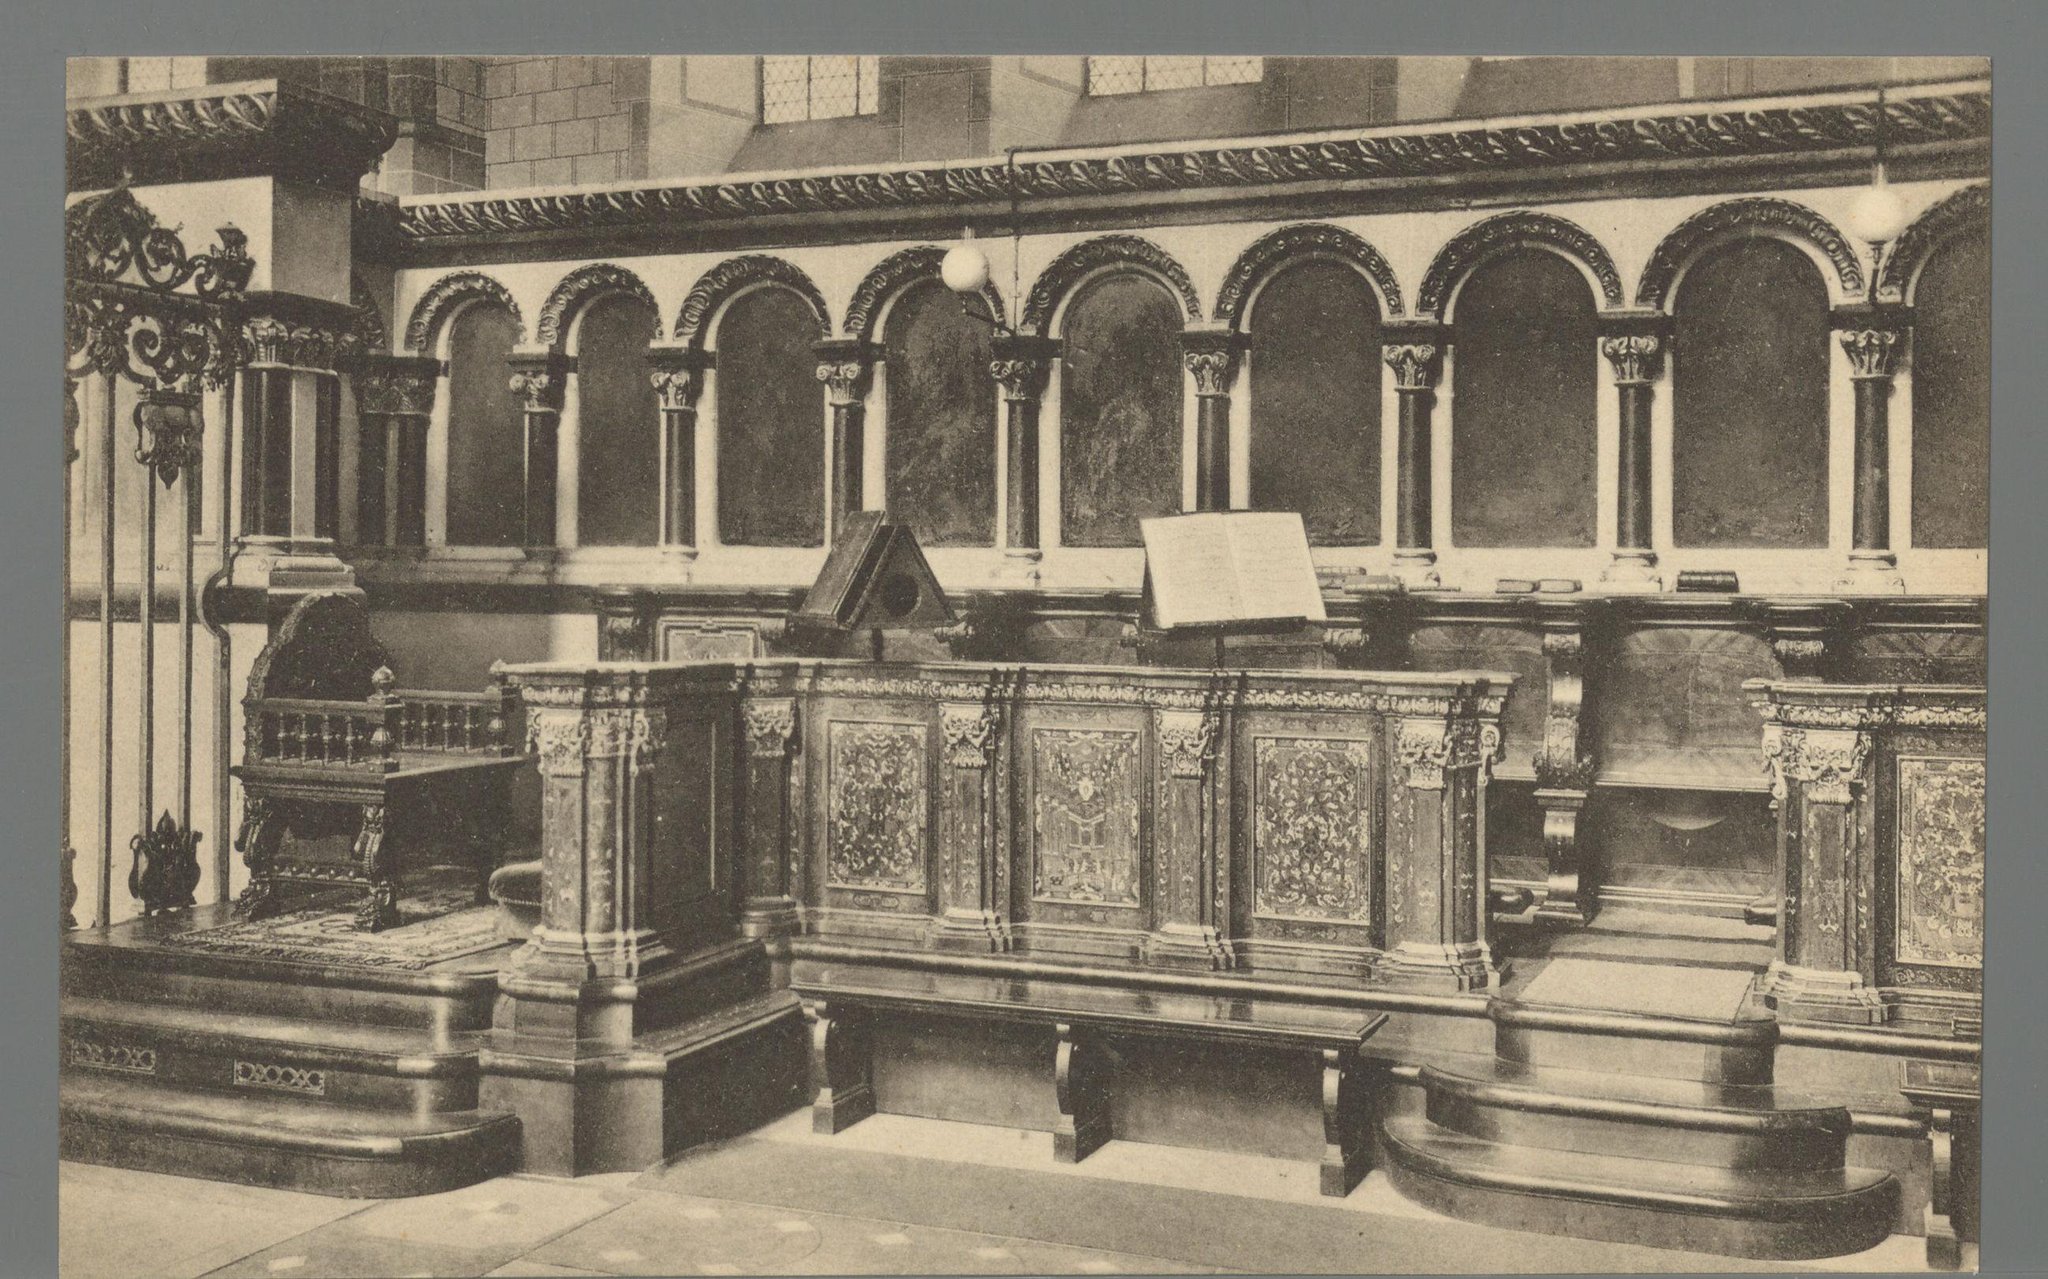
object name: photomechanical print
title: Dom zu Trier. Chorgestühl (1725)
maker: Anonymous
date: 1905-1930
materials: cardboard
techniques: photograph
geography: trier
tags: interior of church, parts of church interior: choir